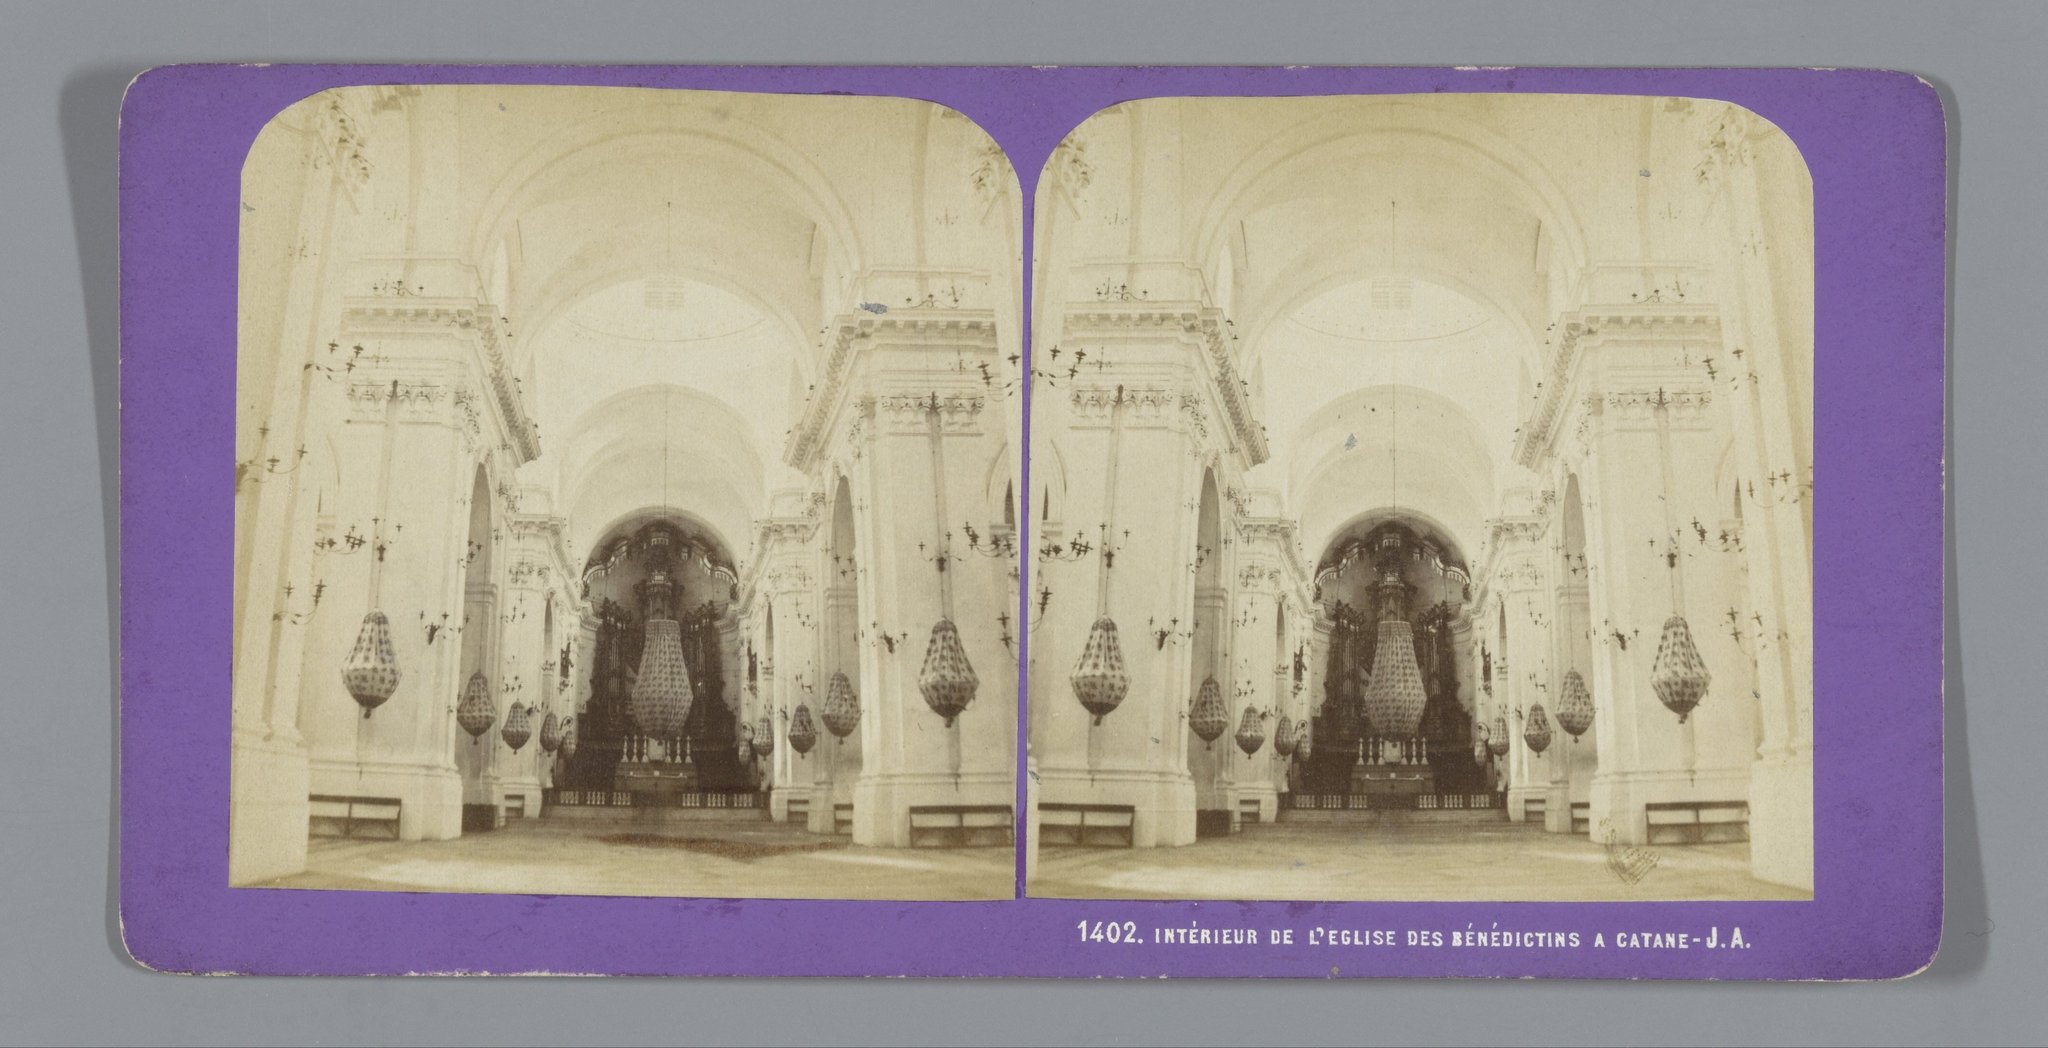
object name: stereograph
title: Intérieur de l'Eglise des Bénédictins a Catane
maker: jean andrieu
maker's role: fotograaf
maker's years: 1816-1872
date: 1862-1876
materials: cardboard, paper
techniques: albumen print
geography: catania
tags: interior of church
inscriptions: number: ‘1402’